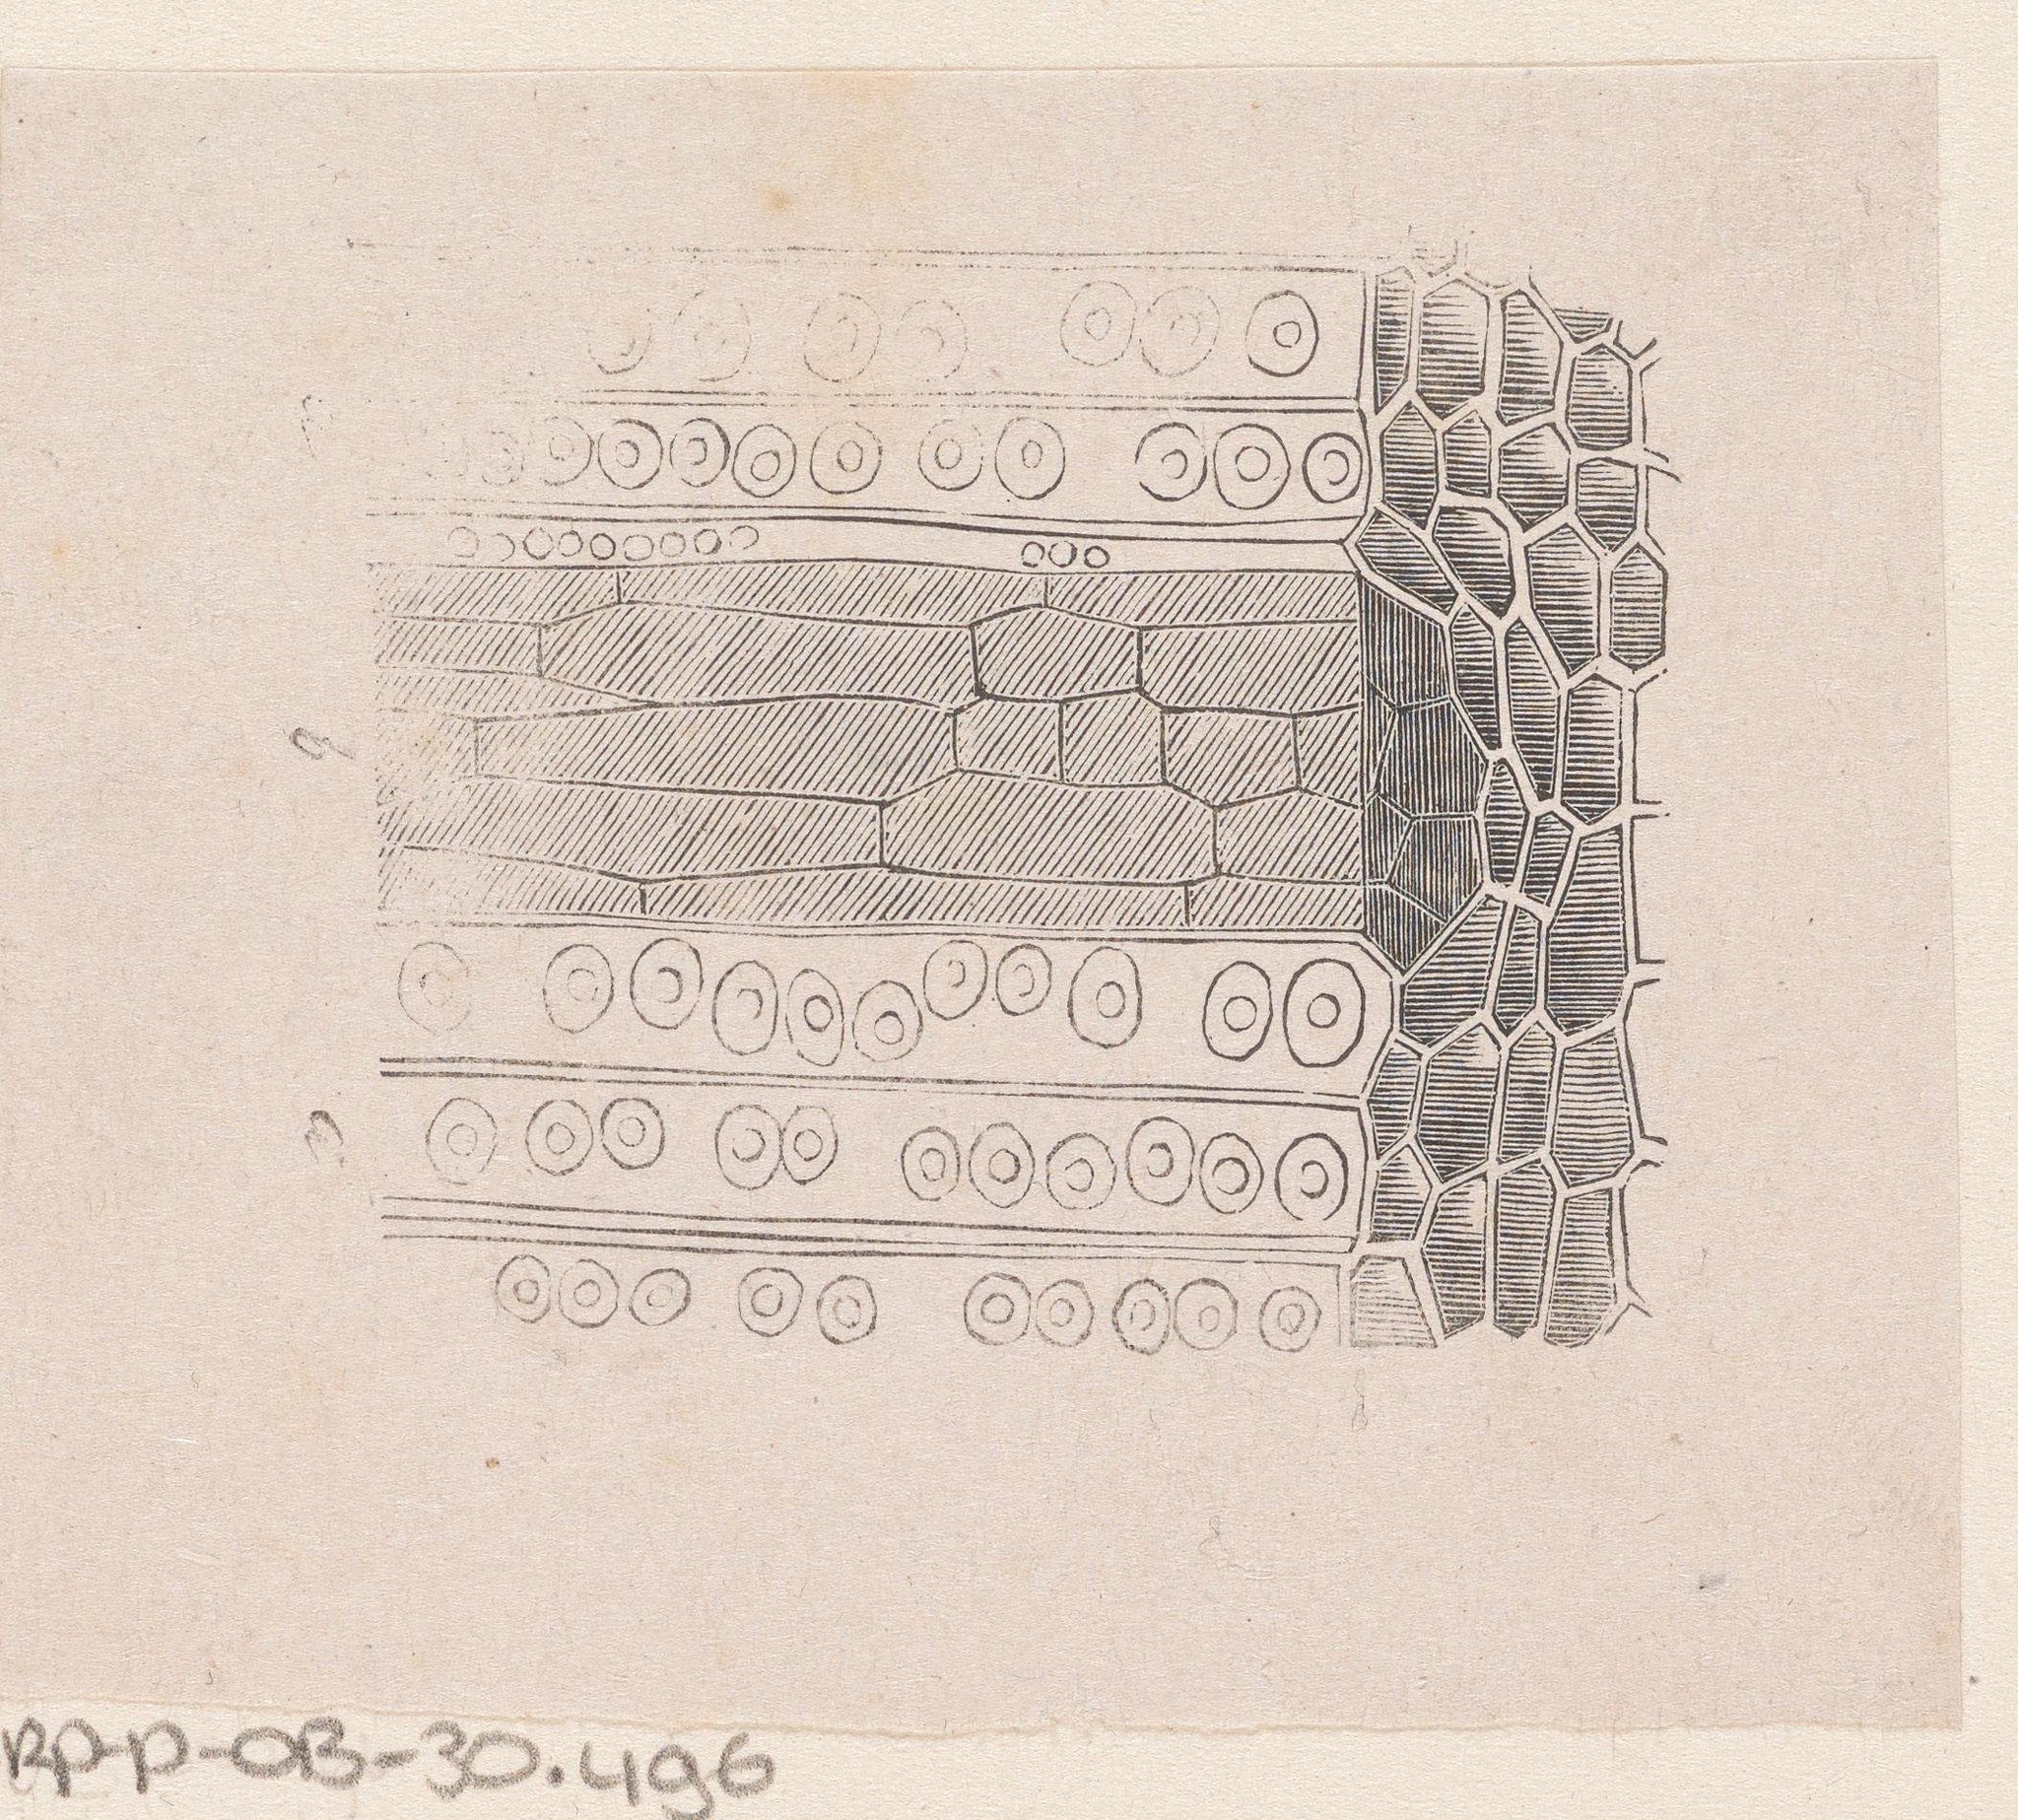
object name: print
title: Cellen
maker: isaac weissenbruch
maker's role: print maker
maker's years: 1826-1912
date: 1836-1912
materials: paper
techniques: engraving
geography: netherlands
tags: biology